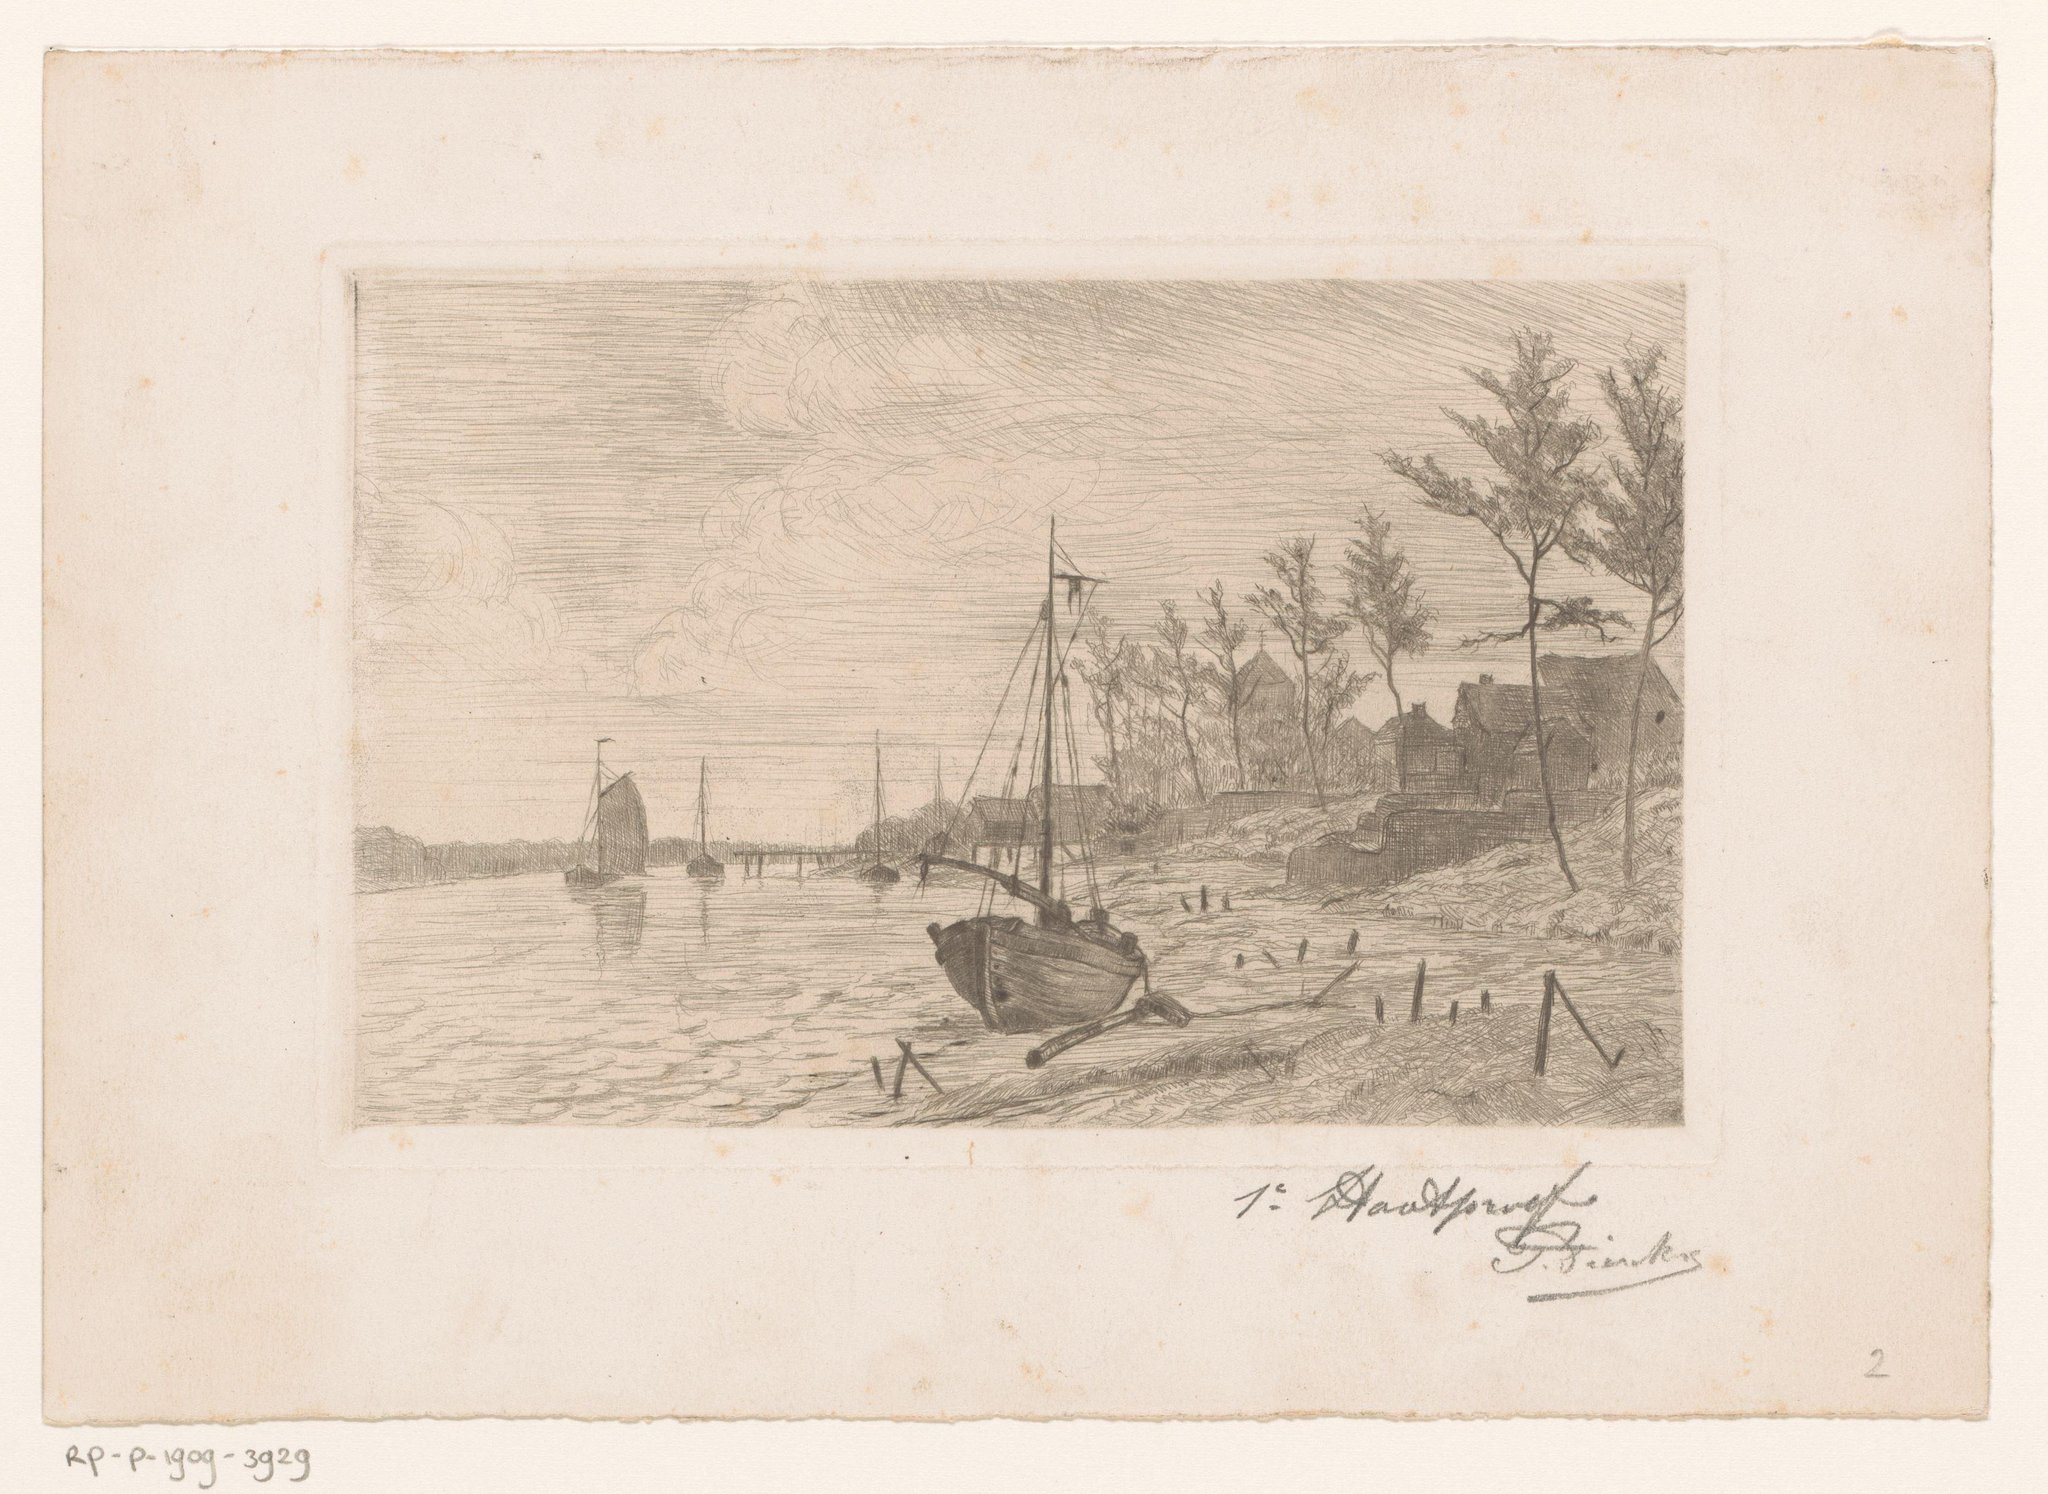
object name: print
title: Dorp aan een rivier met een boot langs de oever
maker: pierre jacques dierckx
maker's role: painter, print maker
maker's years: 1855-1947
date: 1891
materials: paper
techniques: drypoint, etching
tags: prospect of village, silhouette of village, river, ships, boats on land, beached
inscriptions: collector's mark: Lugt 2228, inscription: ‘1e Staatproef’